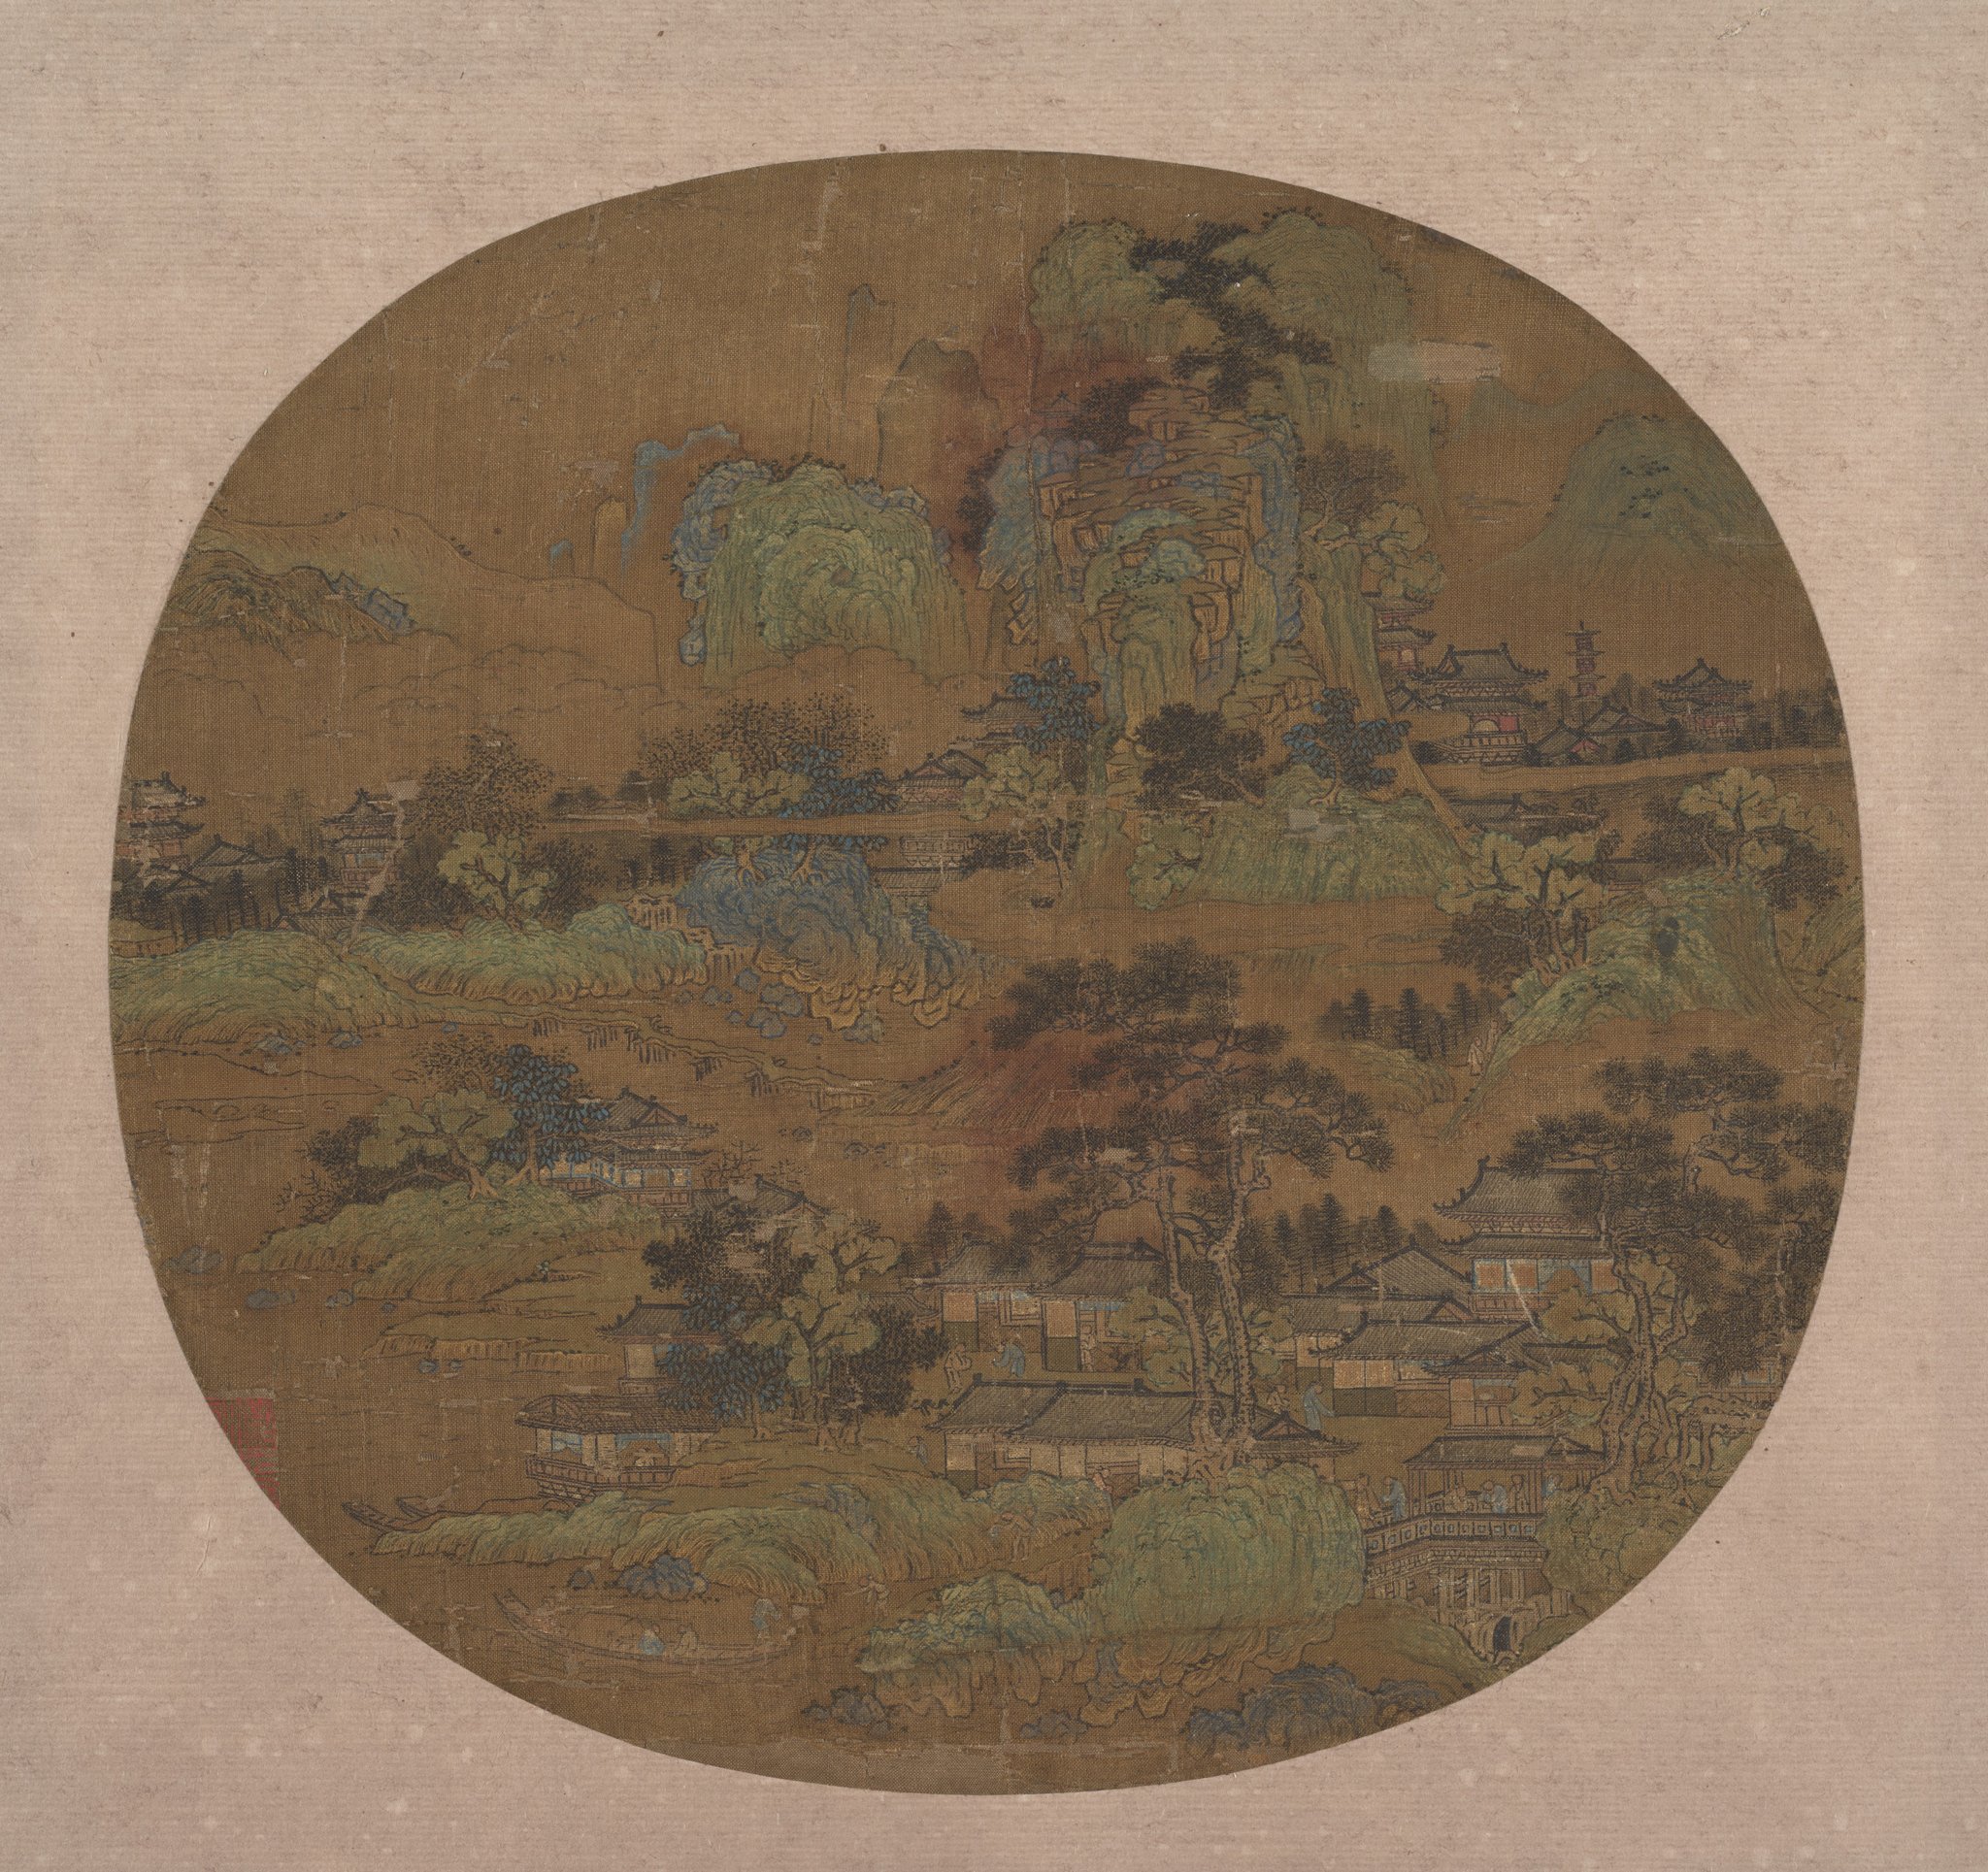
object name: fan mounted a an album leaf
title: Village and Temples in Jiangnan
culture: chinese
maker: unidentified artist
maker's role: artist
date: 1401-1433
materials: gold, ink, silk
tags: temples,villages,landscapes